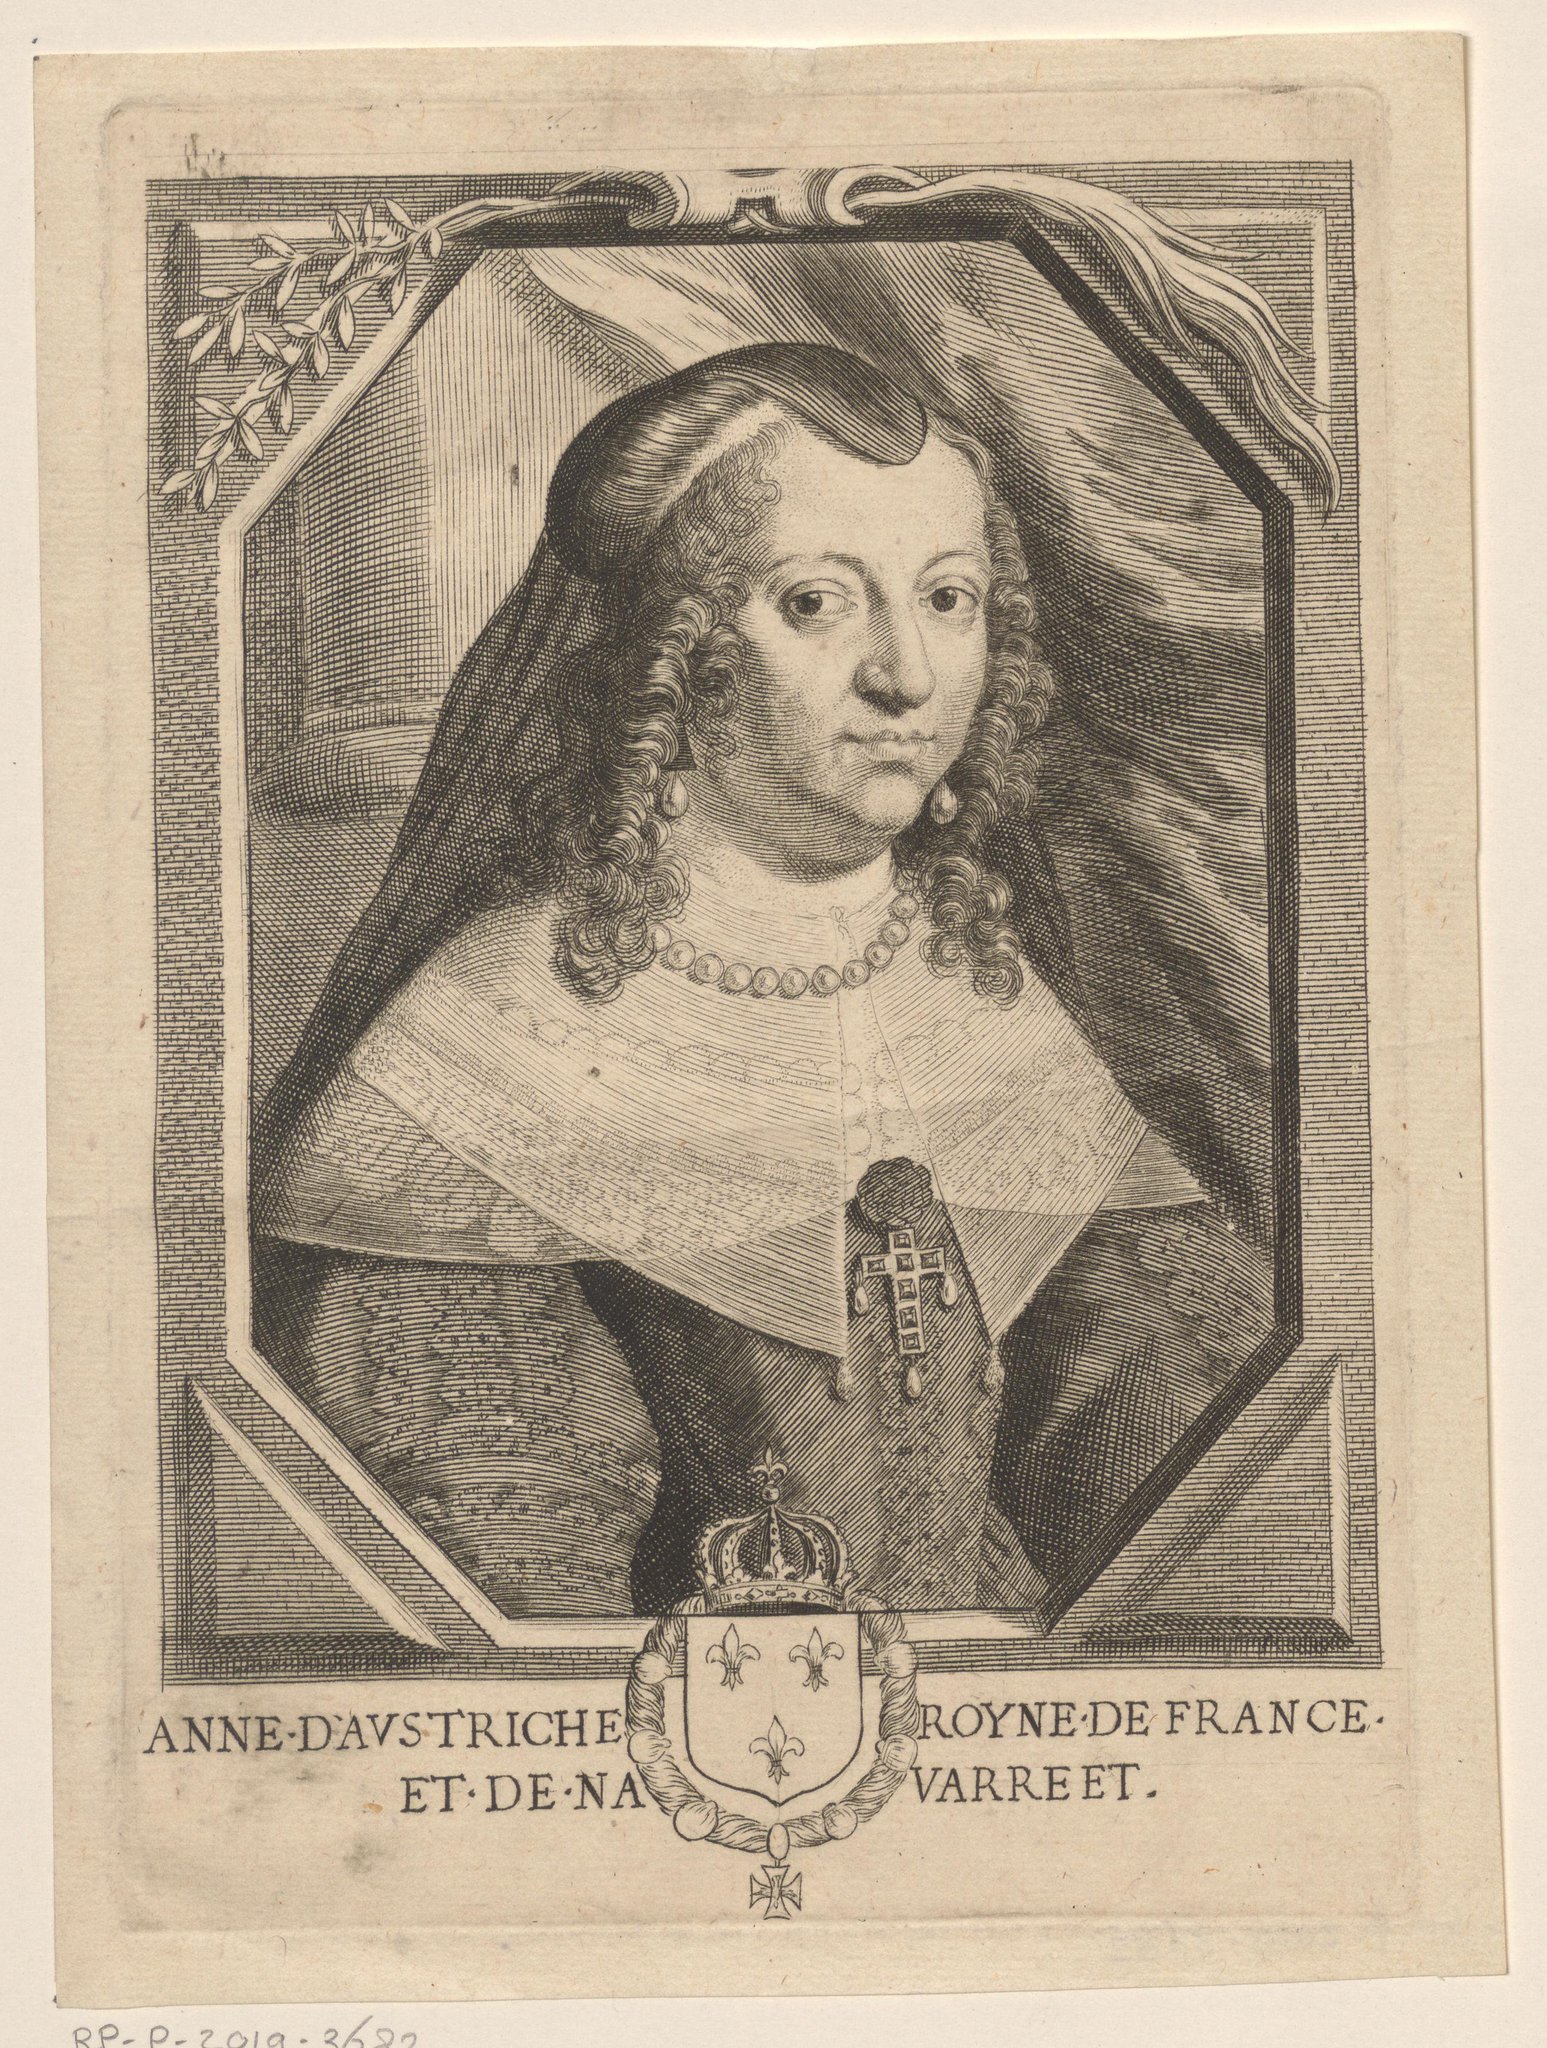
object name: print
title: Portret van Anna van Oostenrijk, koningin van Frankrijk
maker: Anonymous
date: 1615-1643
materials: paper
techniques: engraving, etching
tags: paris, anna van oostenrijk (koningin van frankrijk), historical persons - bb - woman, armorial bearing, heraldry